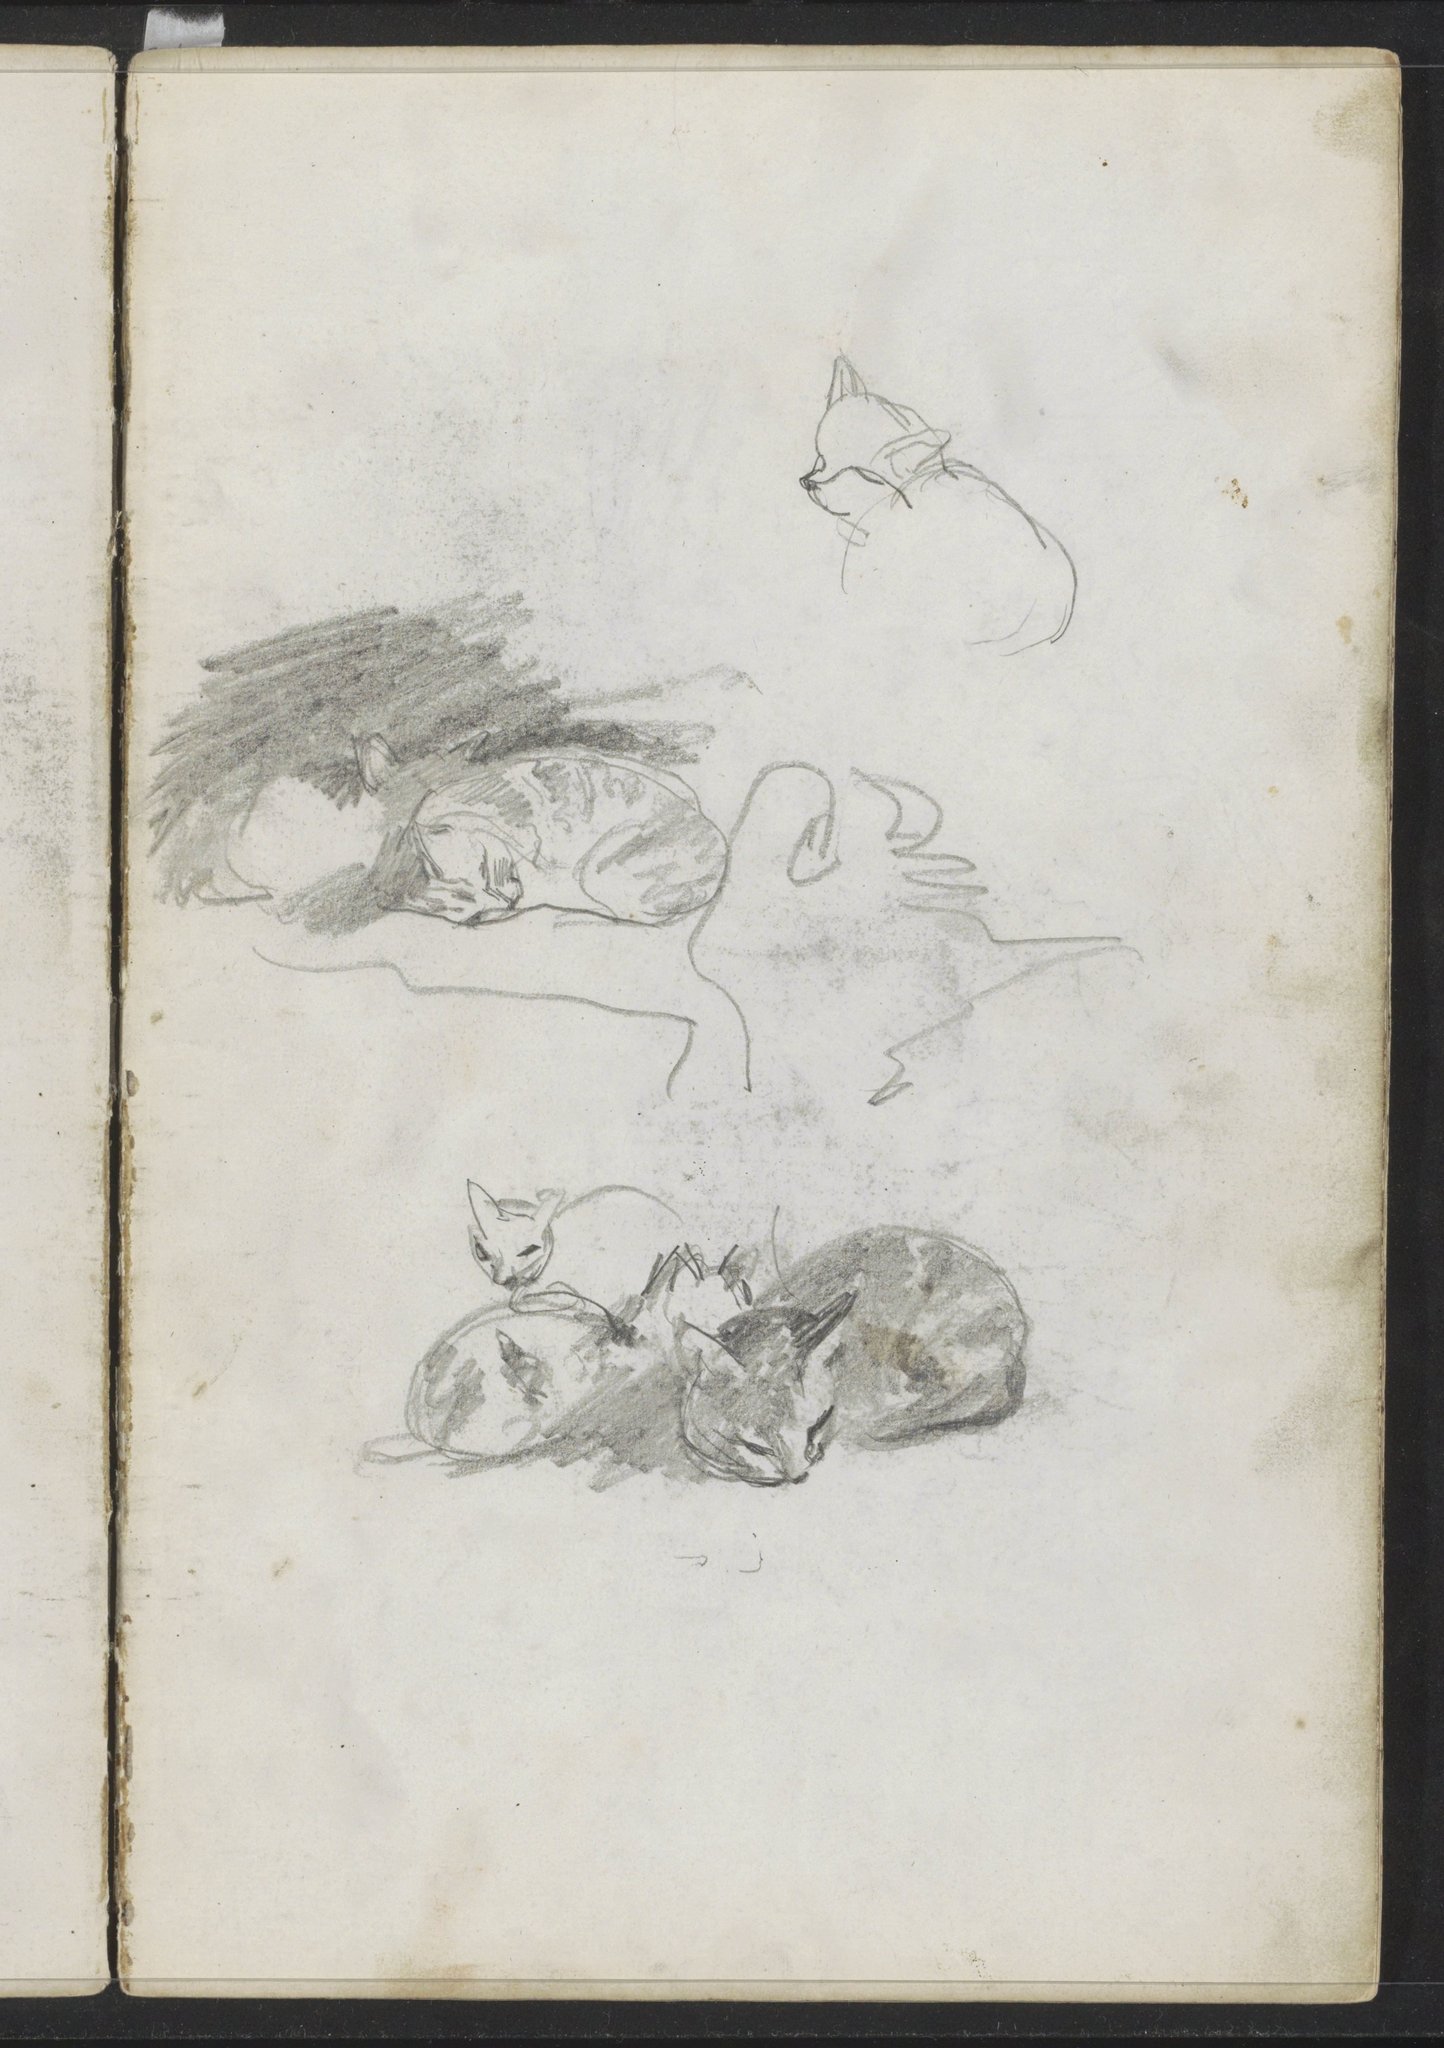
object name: sketchbook leaf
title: Liggende en slapende katten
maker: jozef israëls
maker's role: draughtsman, painter, print maker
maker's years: 1824-1911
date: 1855-1859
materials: paper, pencil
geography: zandvoort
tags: cat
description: Blad 17 recto uit een schetsboek met 22 bladen.